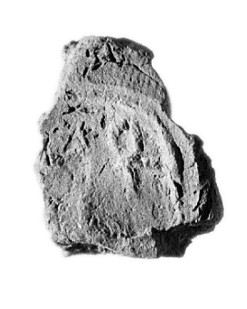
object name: sealing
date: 2030-1640 BCE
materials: clay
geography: egypt